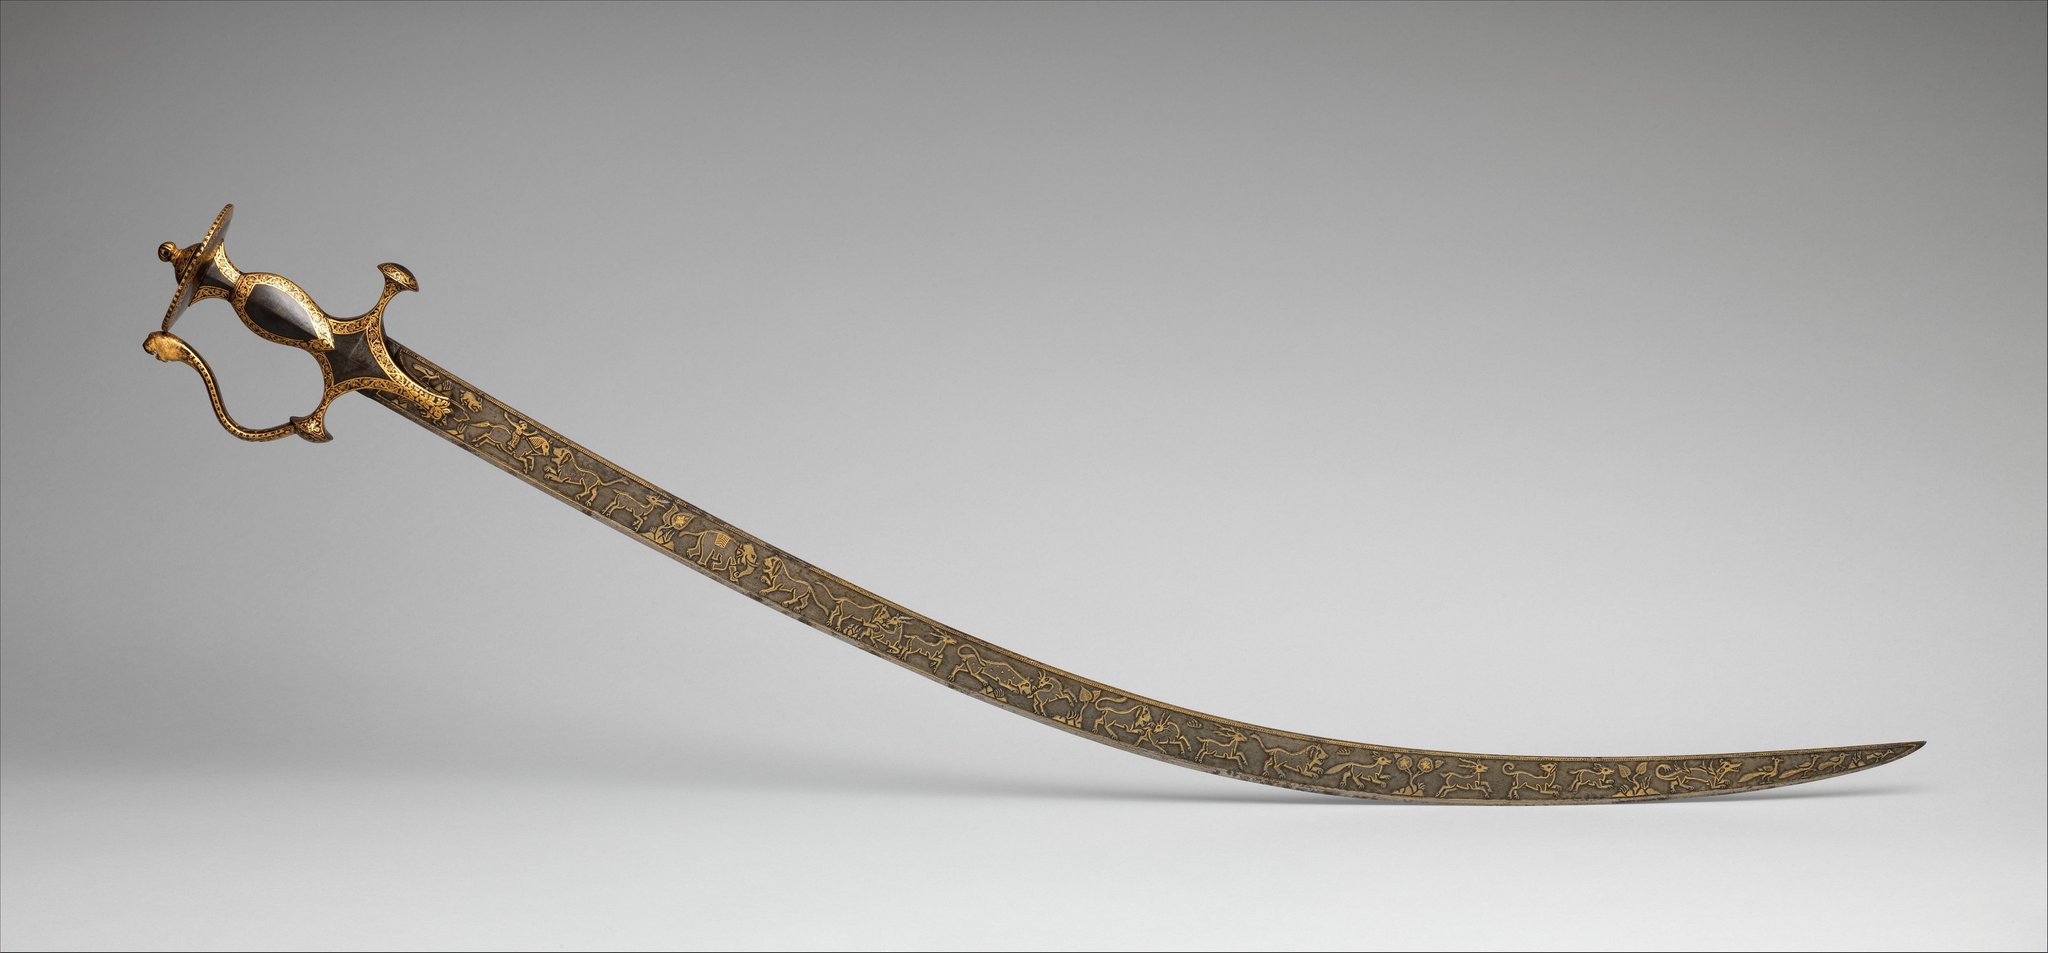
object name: hunting sword shamshir shikargar with modern scabbard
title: Hunting Sword (Shamshir Shikargar) with Modern Scabbard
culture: indian, rajasthani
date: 1701-1866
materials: gold, steel, textile, wood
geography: india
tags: animals,birds,deer,elephants,horses